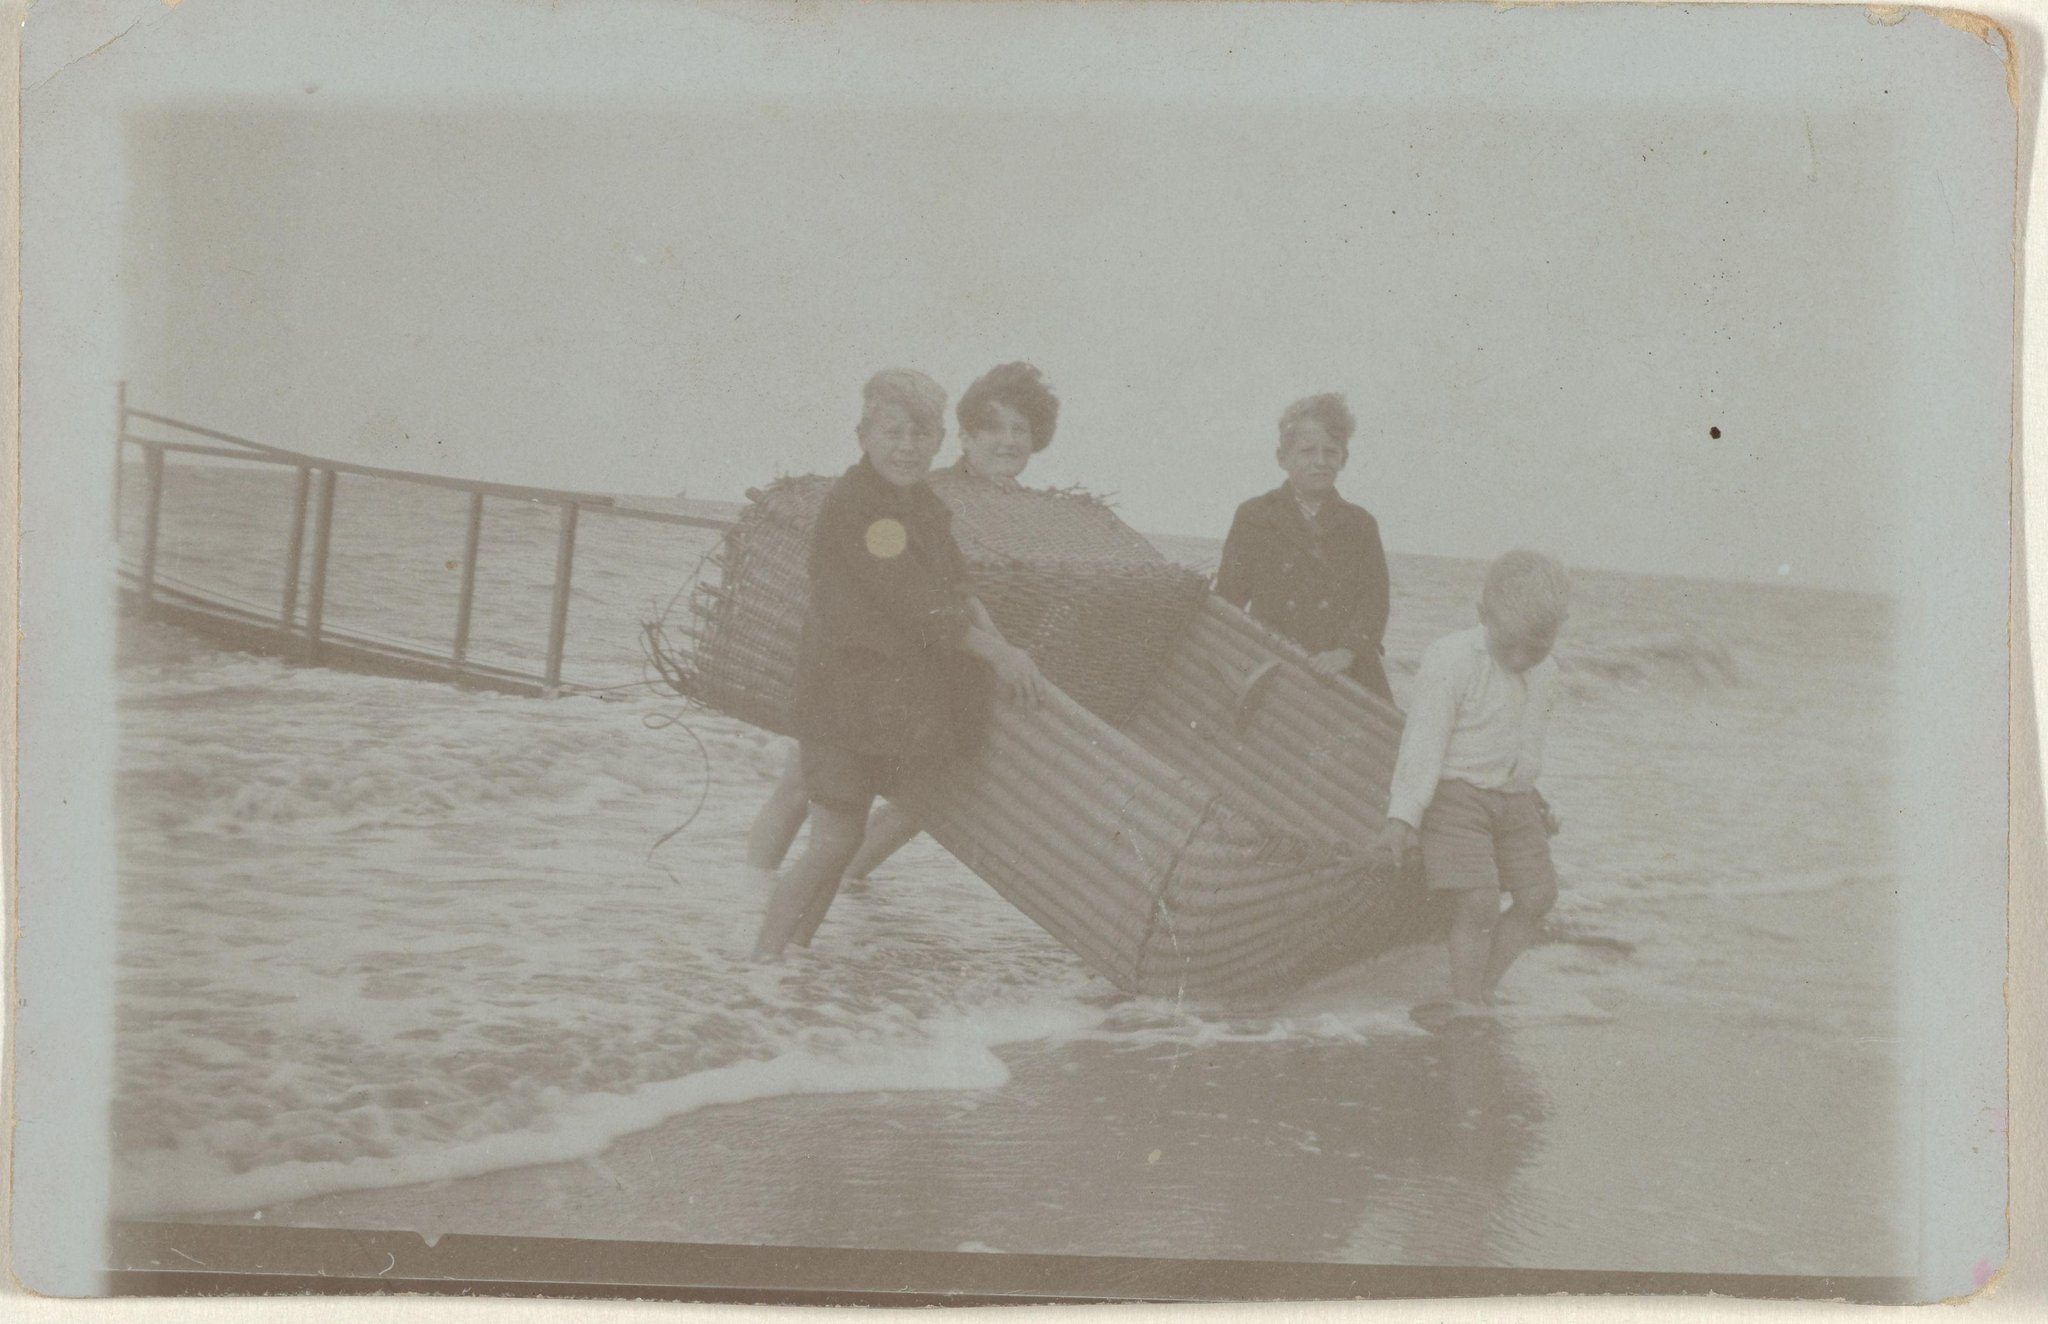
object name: photograph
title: Koosje, Daan en Ben Ochse en een andere jongen dragen een rieten strandstoel uit zee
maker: Anonymous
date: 1925-1935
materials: paper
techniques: collodion silver print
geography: valkeveen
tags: beach (as place of recreation), child (+ four persons)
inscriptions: inscription: ‘AA’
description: Portret van vier personen die een rieten strandstoel uit het water dragen (Vinkeveen?).